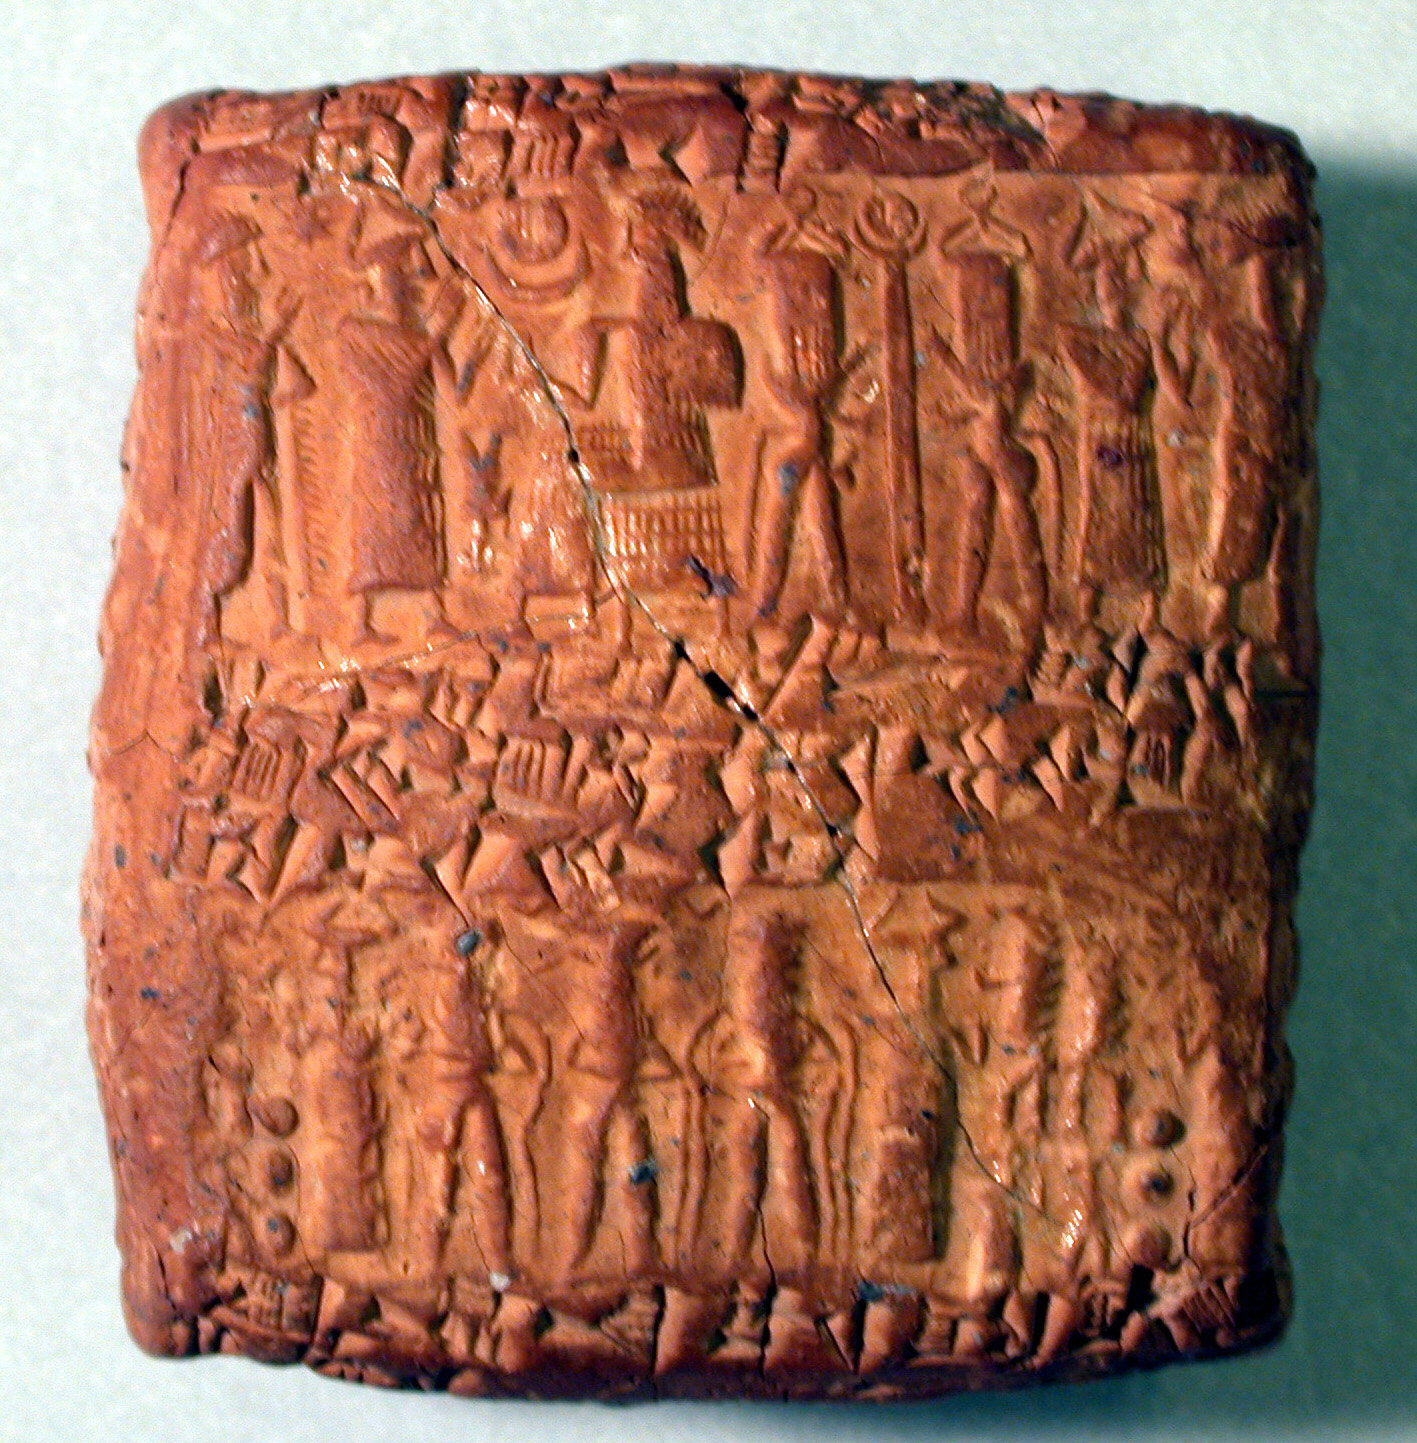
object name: cuneiform tablet case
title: Cuneiform tablet case impressed with three cylinder seals, for cuneiform tablet 66.246.18a: quittance for a loan in copper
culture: assyrian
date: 2000-1801 BCE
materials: clay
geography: anatolia